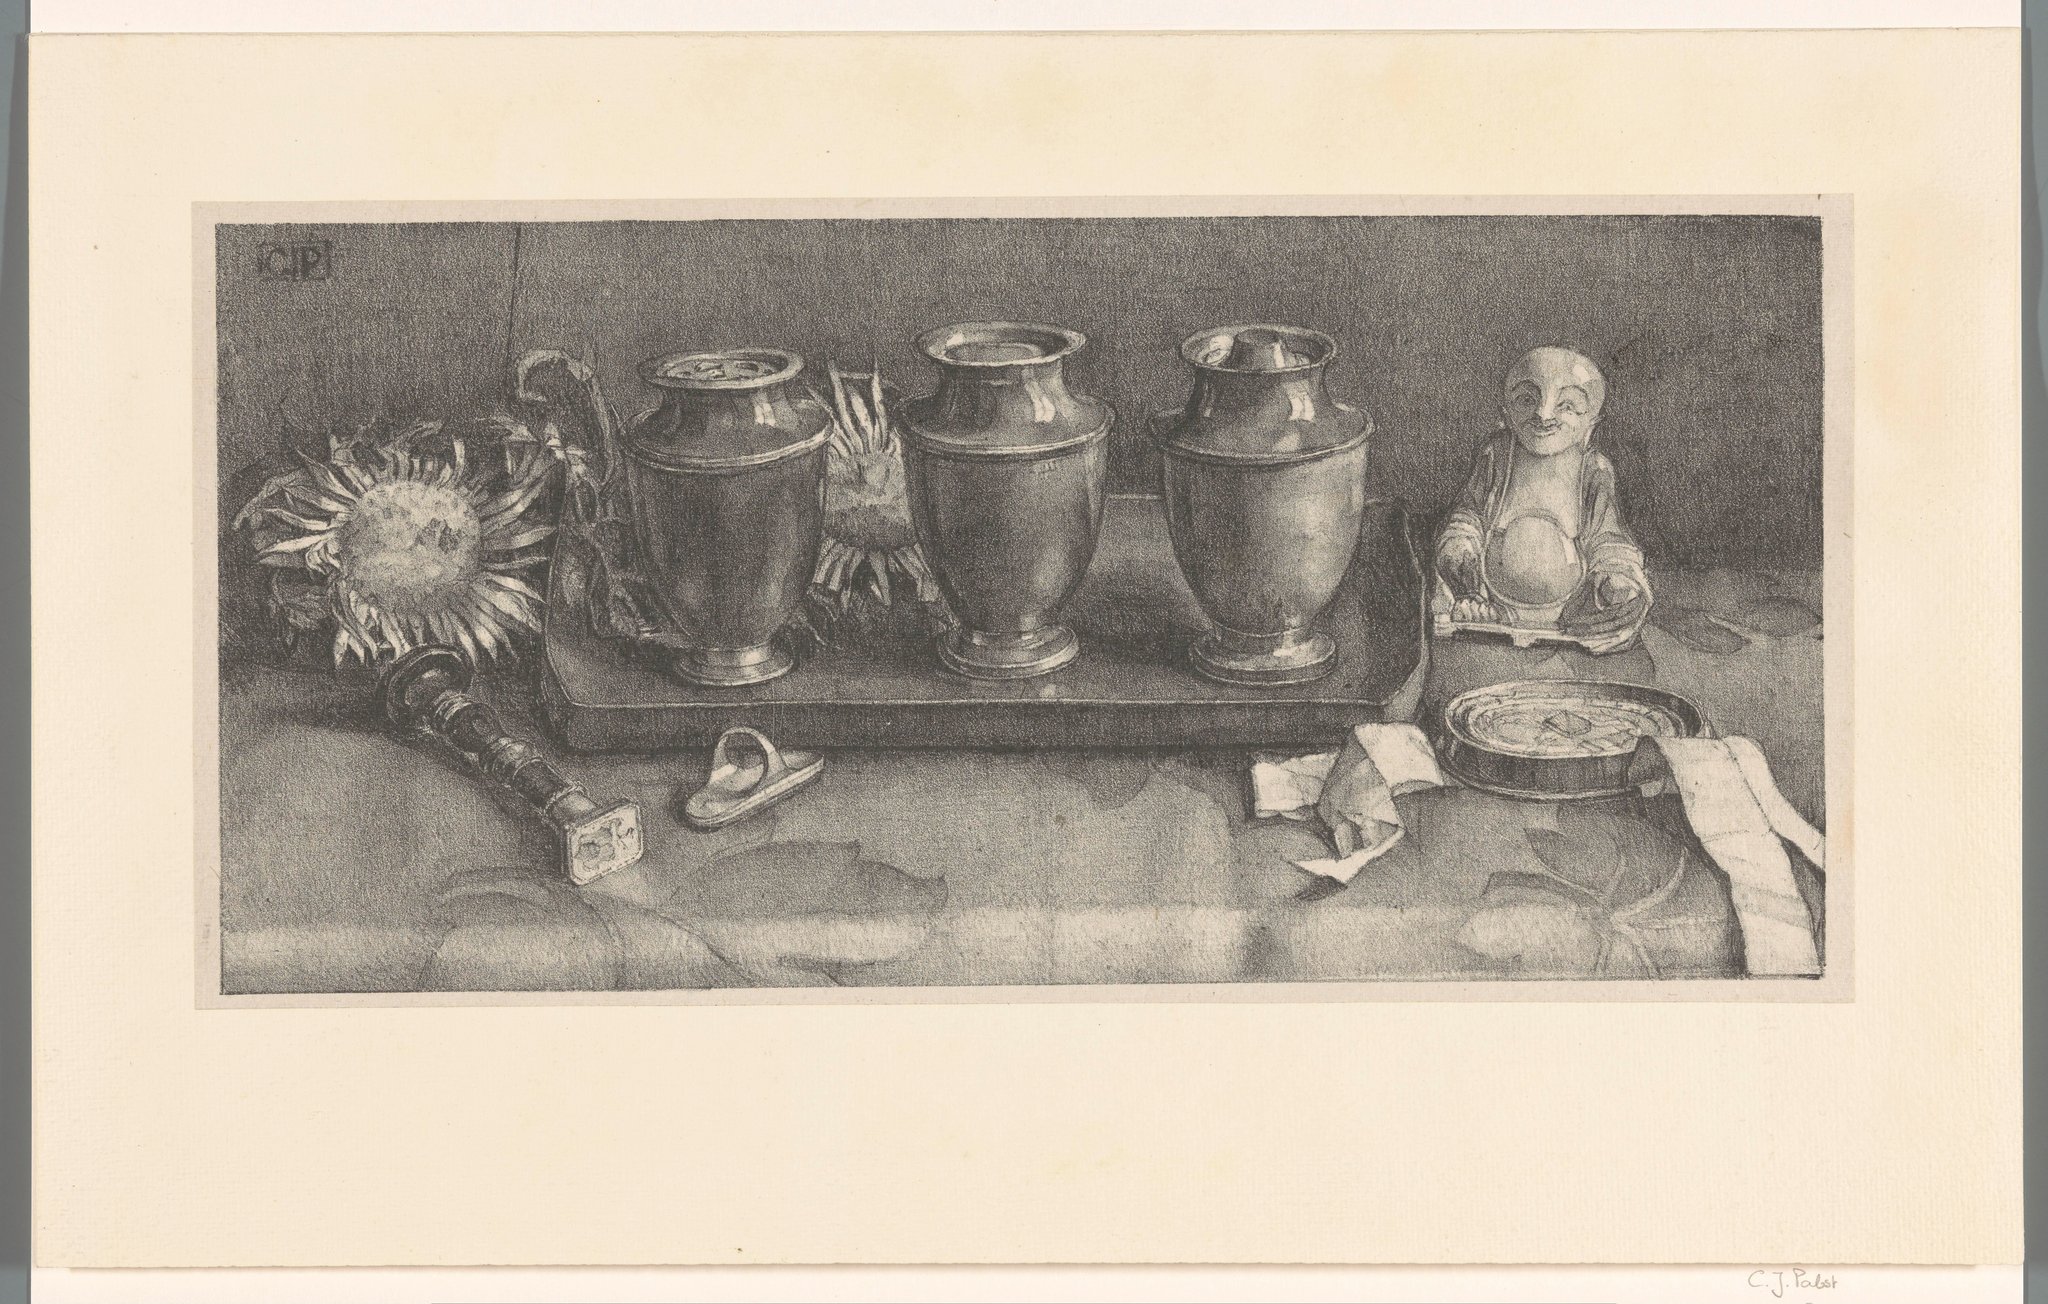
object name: print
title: Stilleven met een dienblad, drie vaten, een kandelaar, een ring, een bloem en een Boeddhabeeld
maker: corrie pabst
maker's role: print maker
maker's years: 1866-1943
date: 1876-1931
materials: paper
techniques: lithograph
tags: still life of miscellaneous objects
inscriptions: collector's mark: Lugt 2228